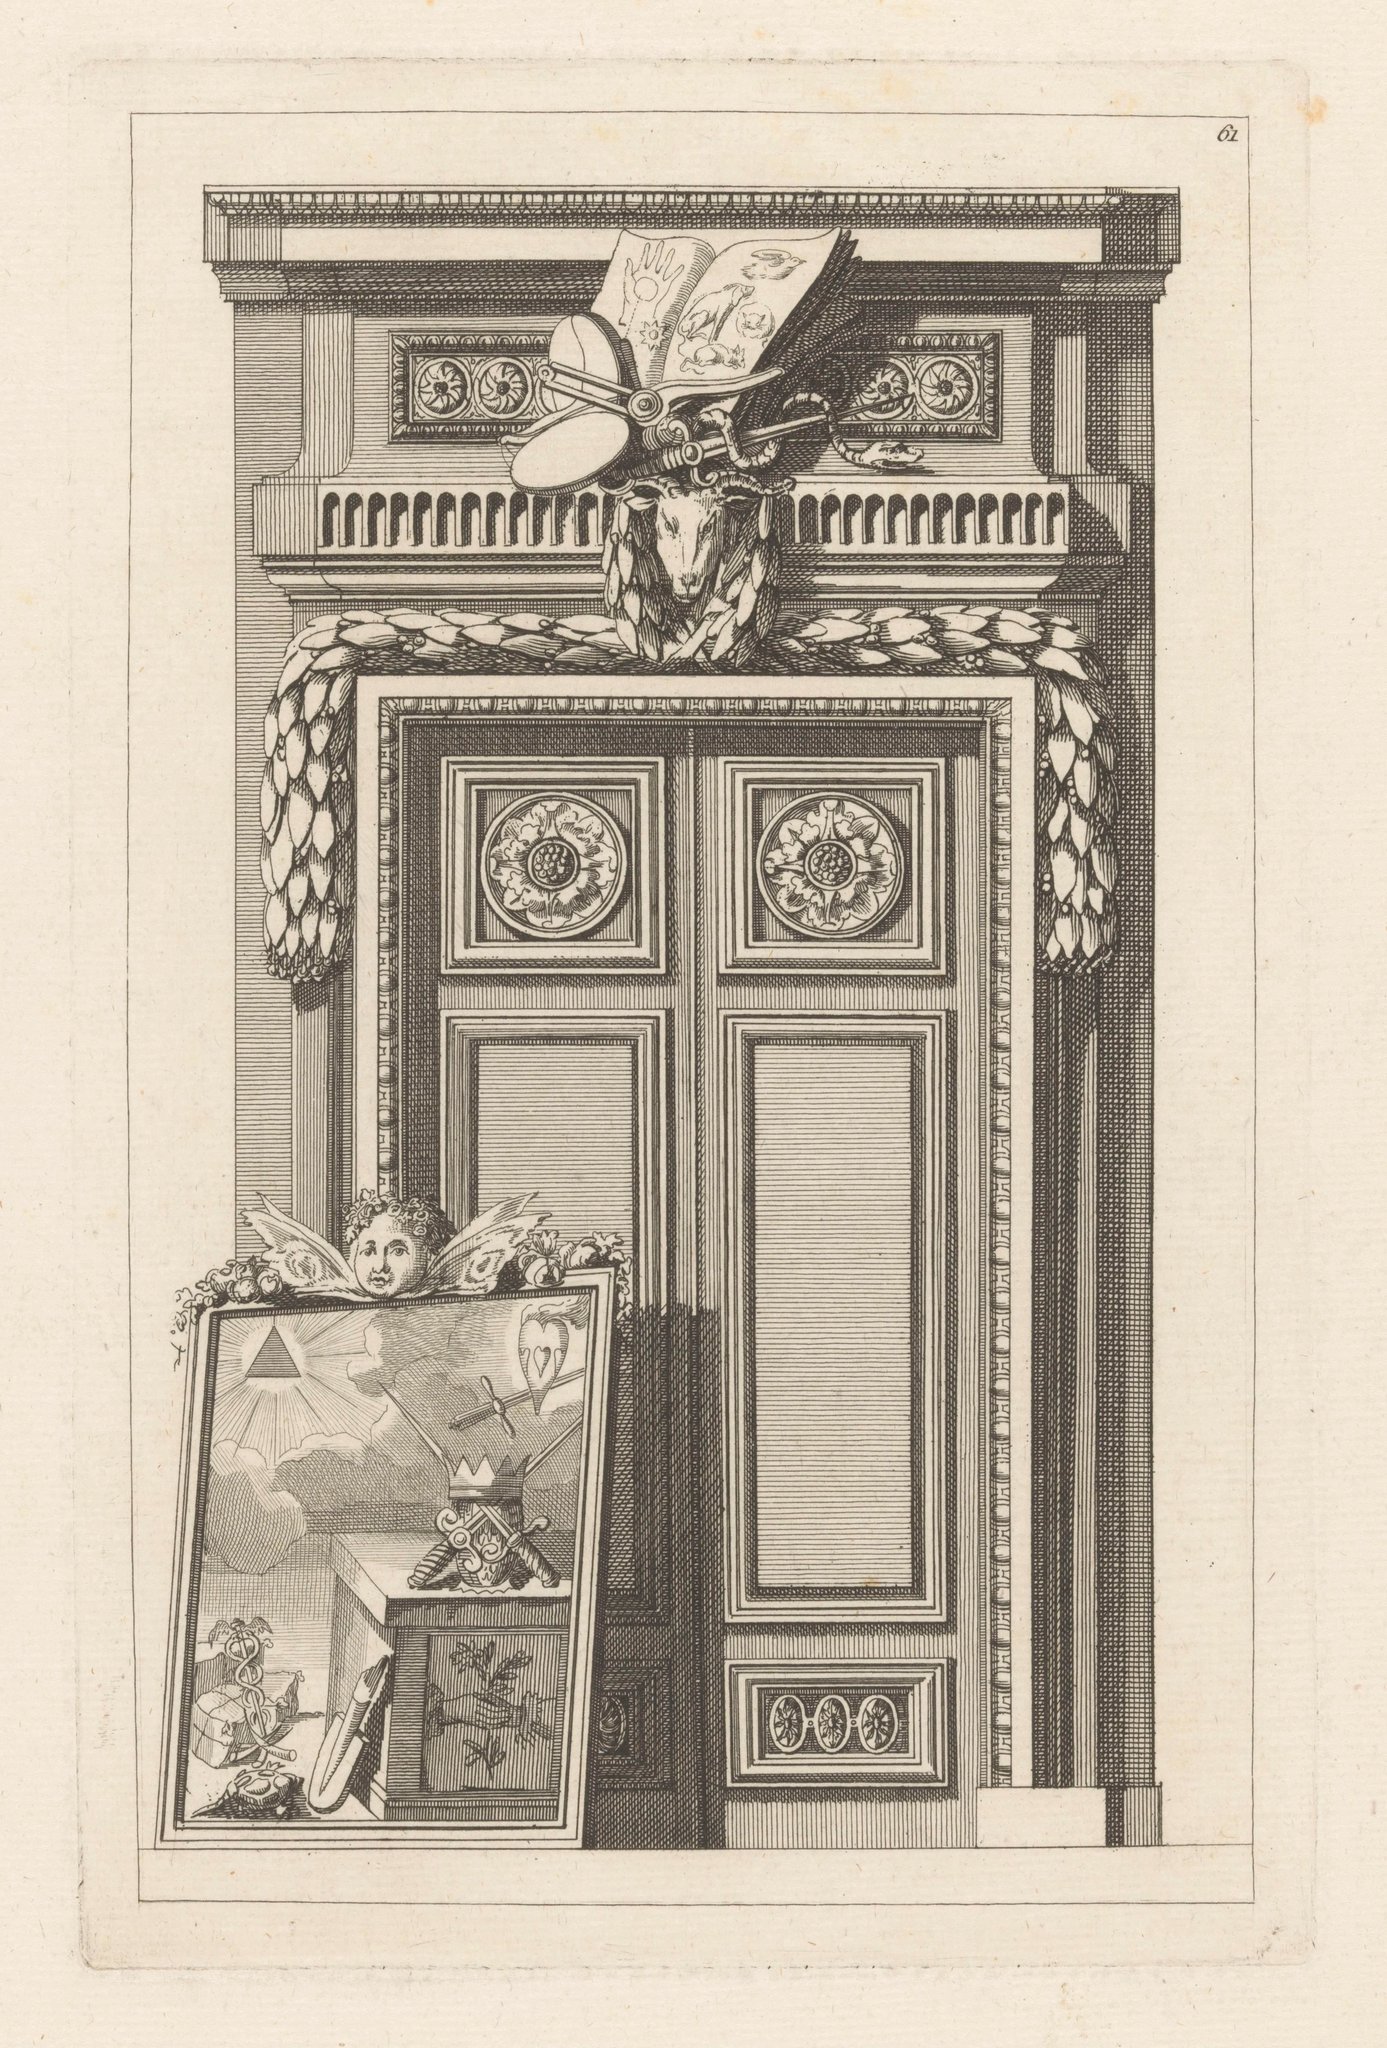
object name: ornament print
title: Deur met bokkenkop en boek met tekeningen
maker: Anonymous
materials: paper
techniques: engraving, etching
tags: book in which illustrations are essential, he-goat, billy-goat, door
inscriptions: collector's mark: Lugt 2228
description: Een geornamenteerde deur met bokkenkop, een zwaard, een slang en een boek met tekeningen. Links een rechthoekige lijst met landschap aan zee, een kroon met twee zwaarden, een brandend hart, een schildpad en een caduceus. Rechts boven 61 genummerd.